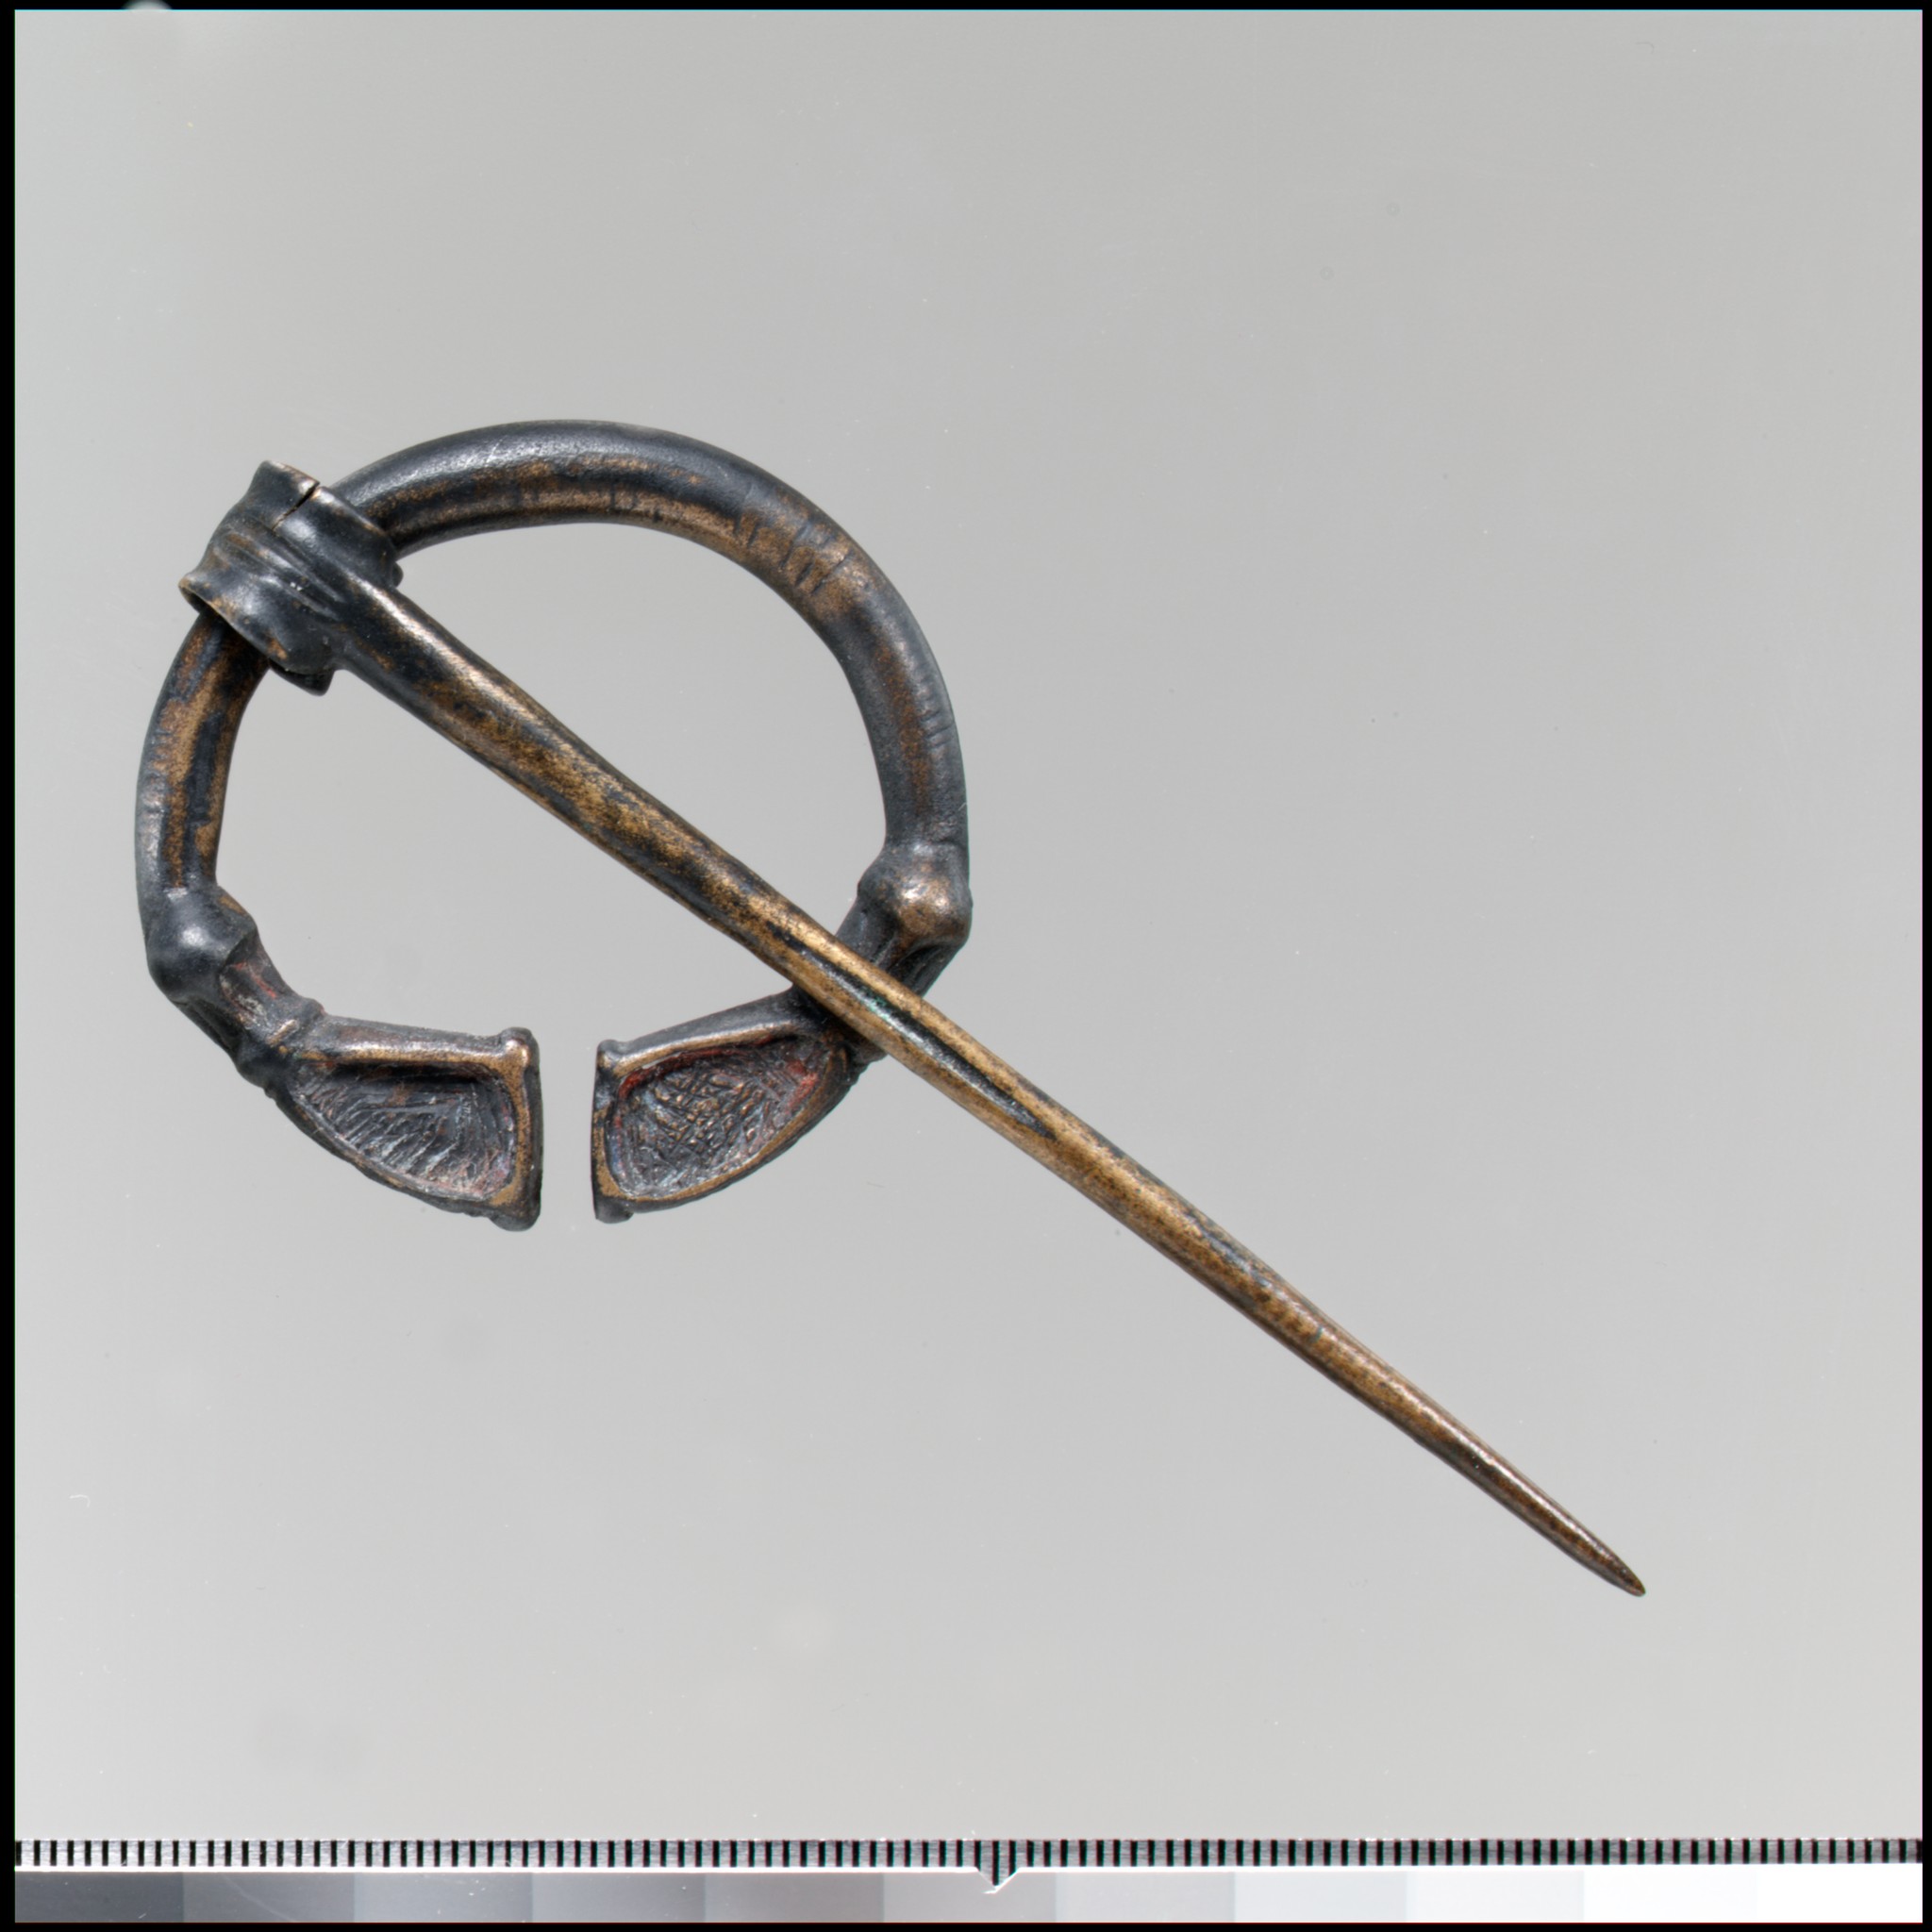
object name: brooch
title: Penannular Brooch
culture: irish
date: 501-700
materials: bronze